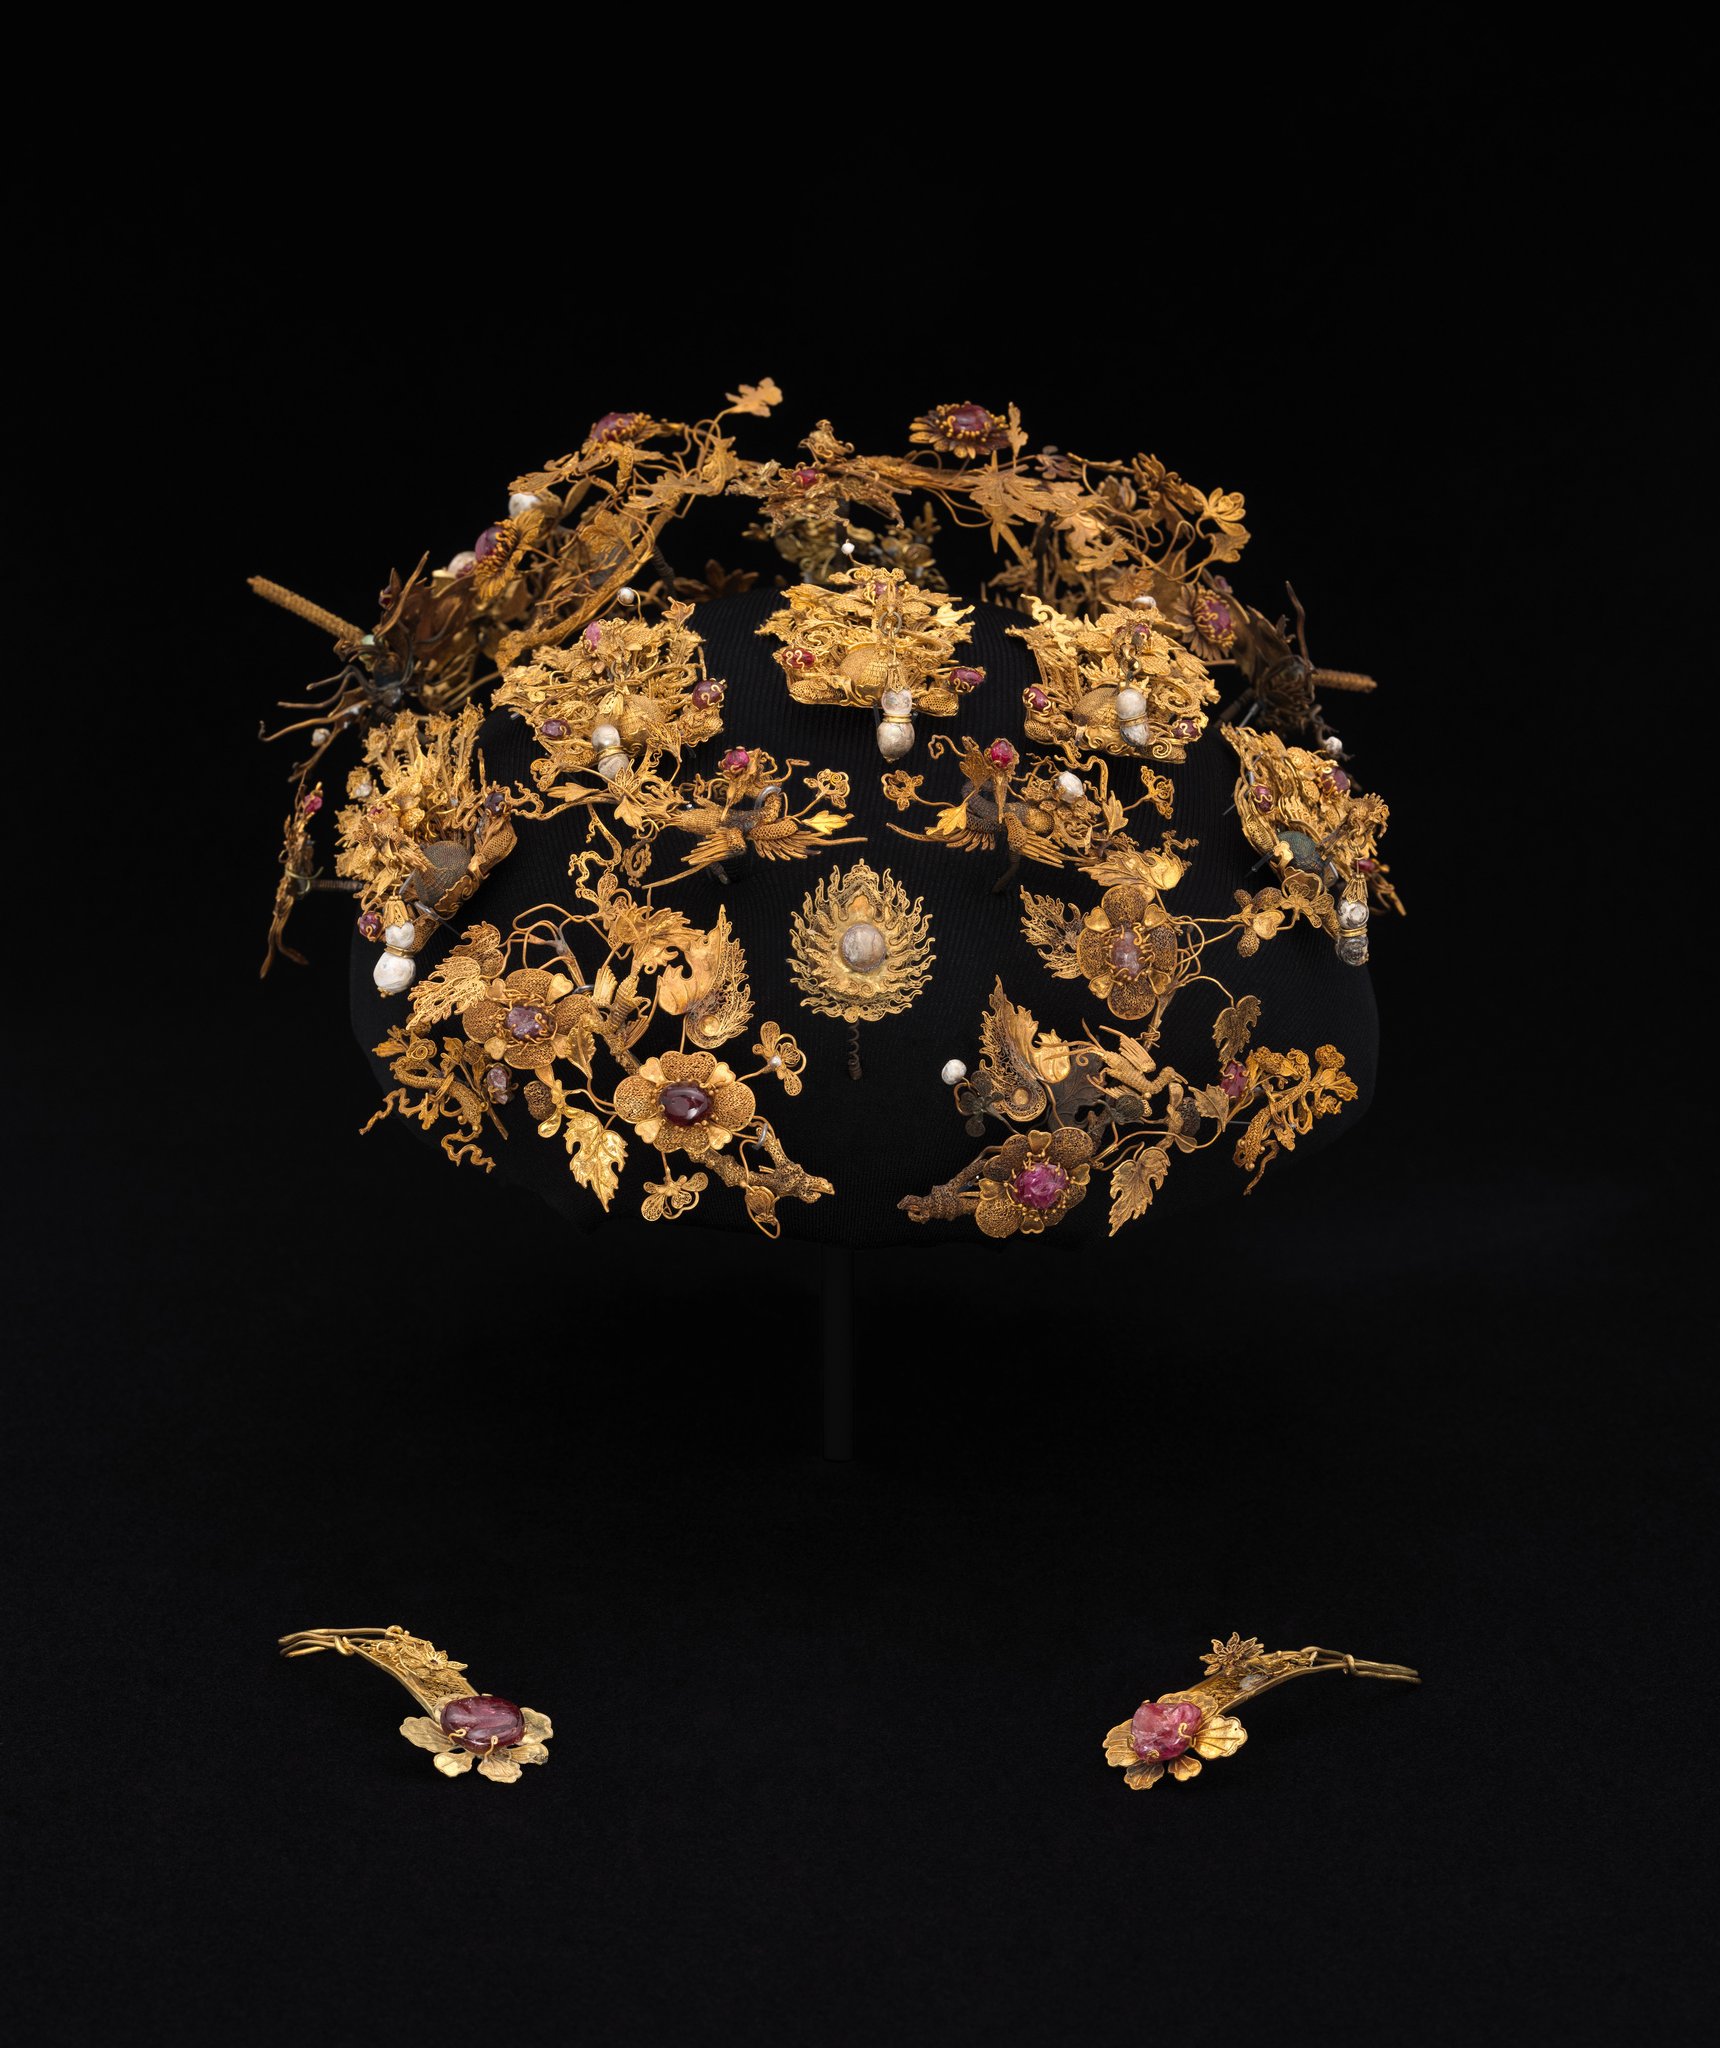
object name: head ornament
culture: chinese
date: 960-1279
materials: gold, iron, pearl, gemstone